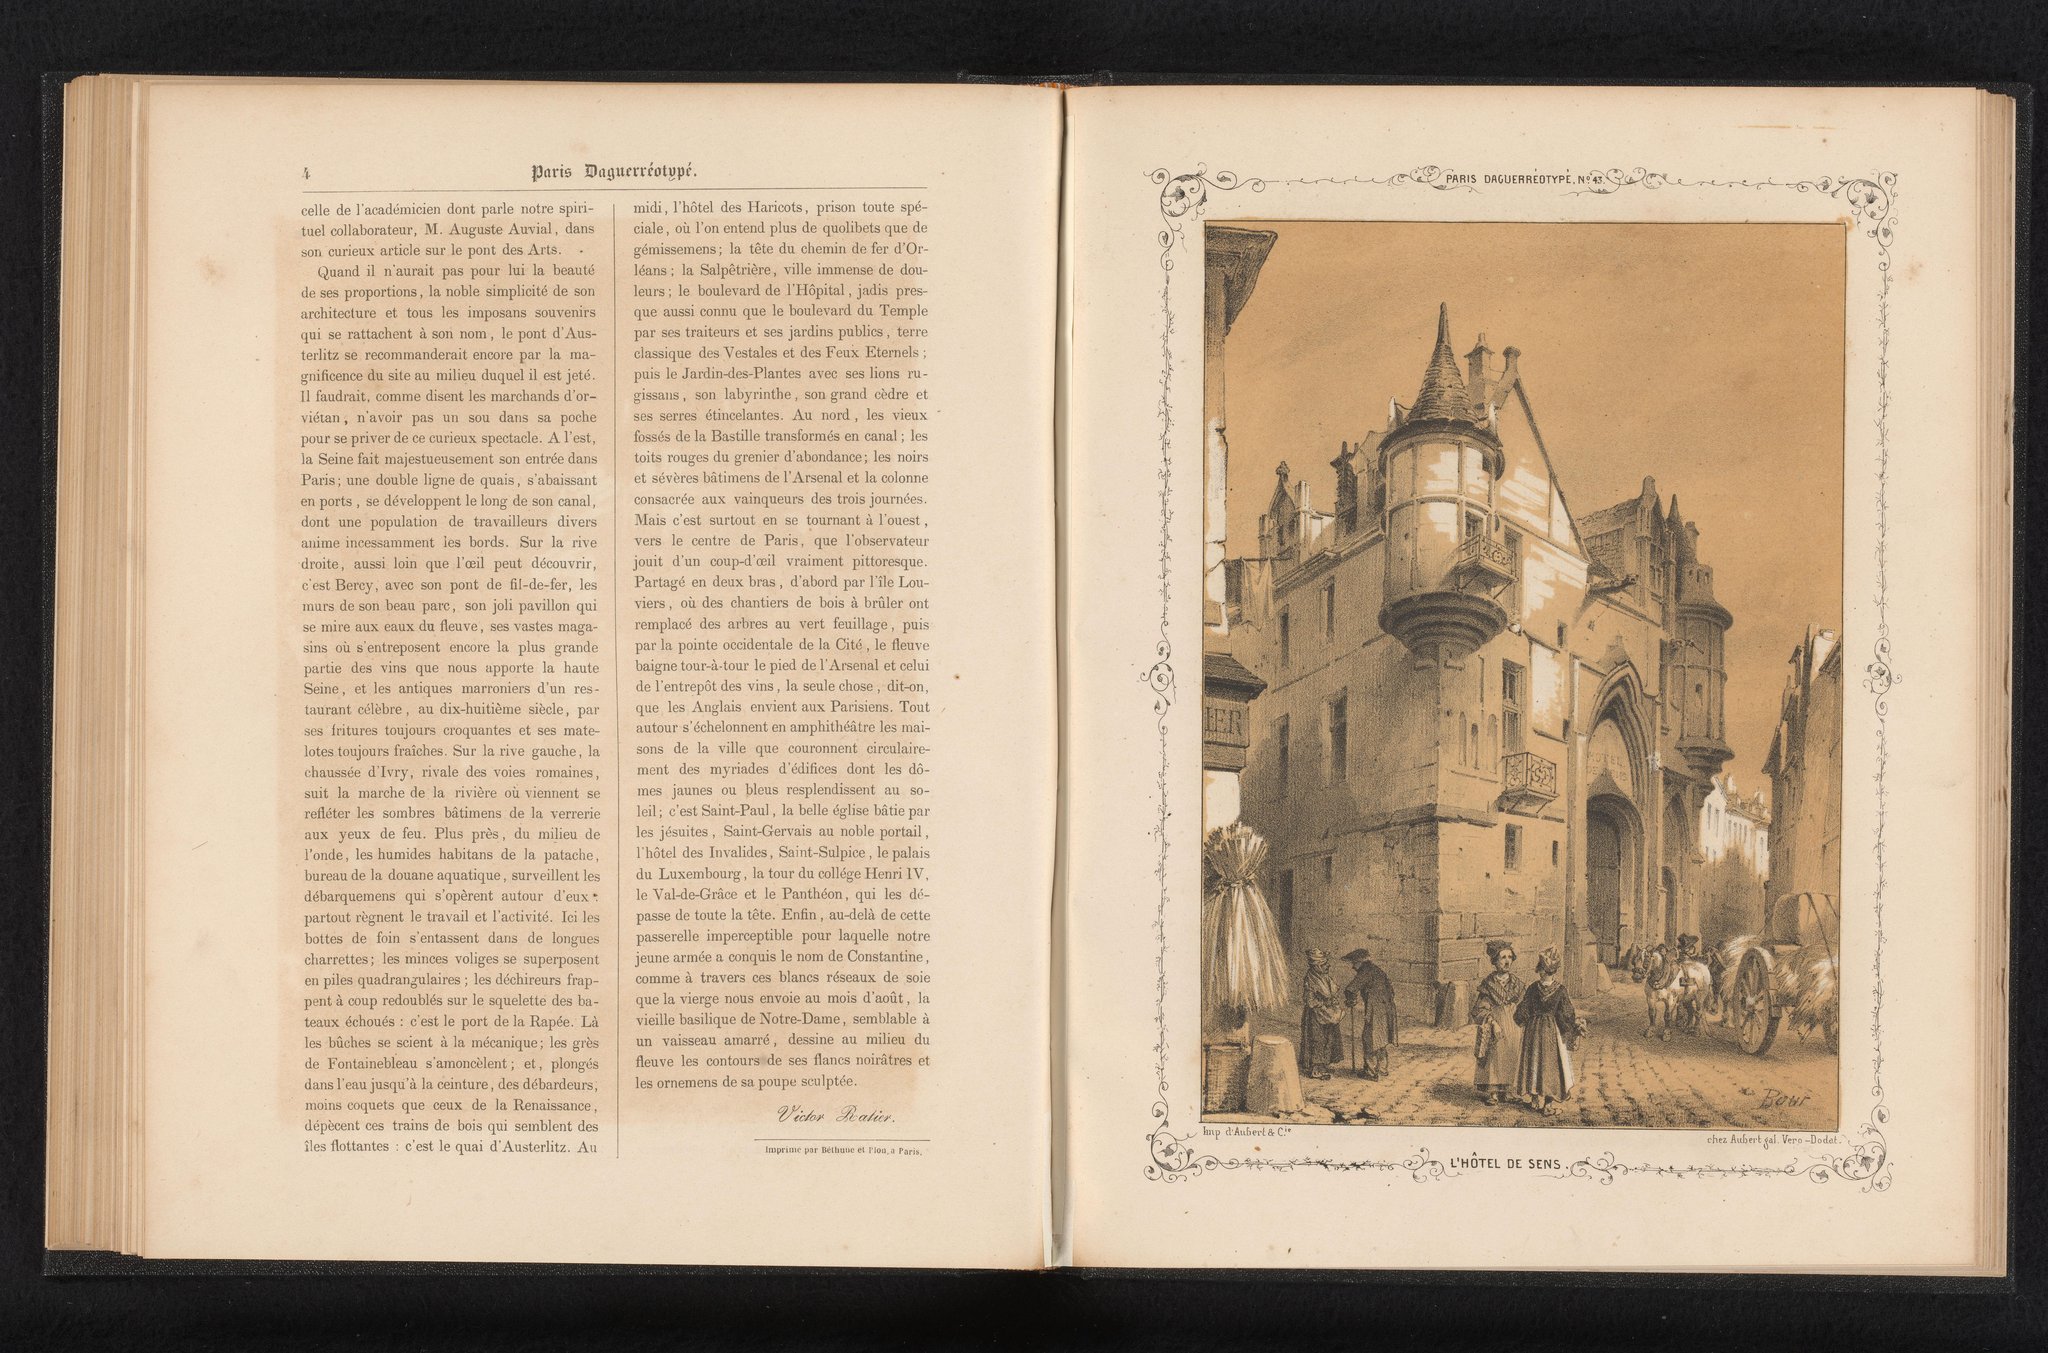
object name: print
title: Gezicht op het Hôtel de Sens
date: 1839-1840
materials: paper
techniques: tone lithography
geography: paris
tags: hôtel, i.e. small palace in city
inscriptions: inscription: ‘PARIS DAGUERRÉOTYPÉ No. 43.’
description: Prent op honderdeenenzeventigste ongenummerde pagina.